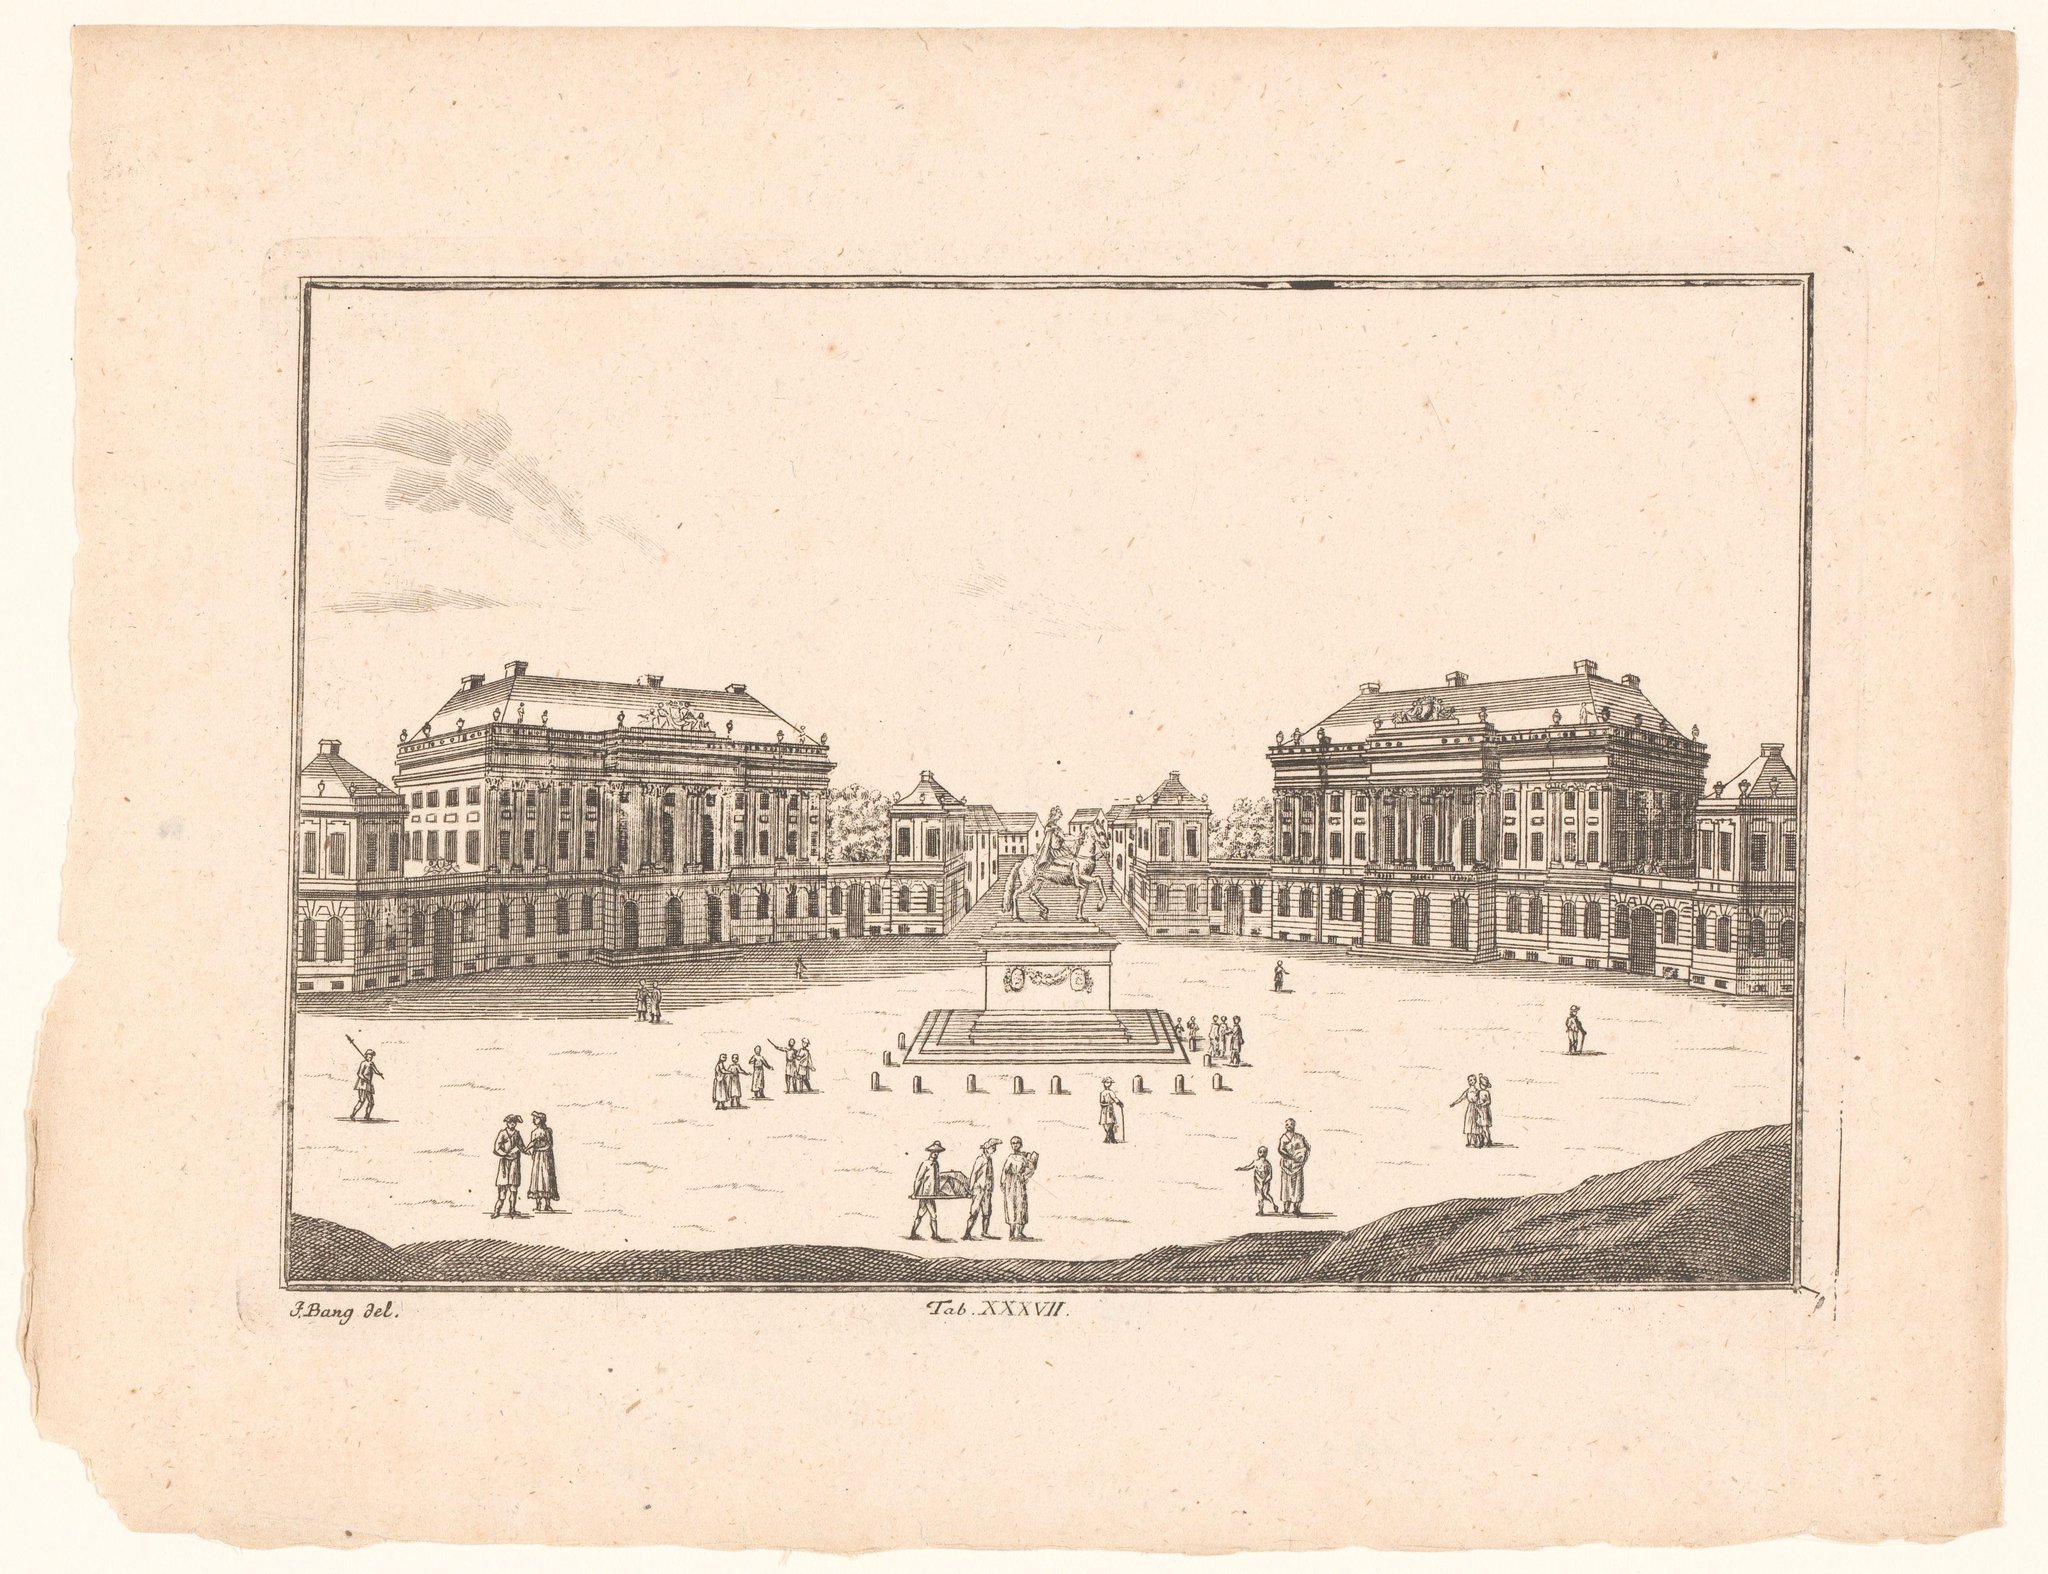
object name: print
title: Ruiterstandbeeld op het plein van Amaliënborg, te Kopenhagen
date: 1750-1808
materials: paper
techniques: engraving, etching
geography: copenhagen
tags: square, place, circus, etc., palace, monument, statue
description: Ruiterstandbeeld op plein voor twee van de vier Amaliënborg-paleizen te Kopenhagen. Onder, in het midden, genummerd: XXXVII.